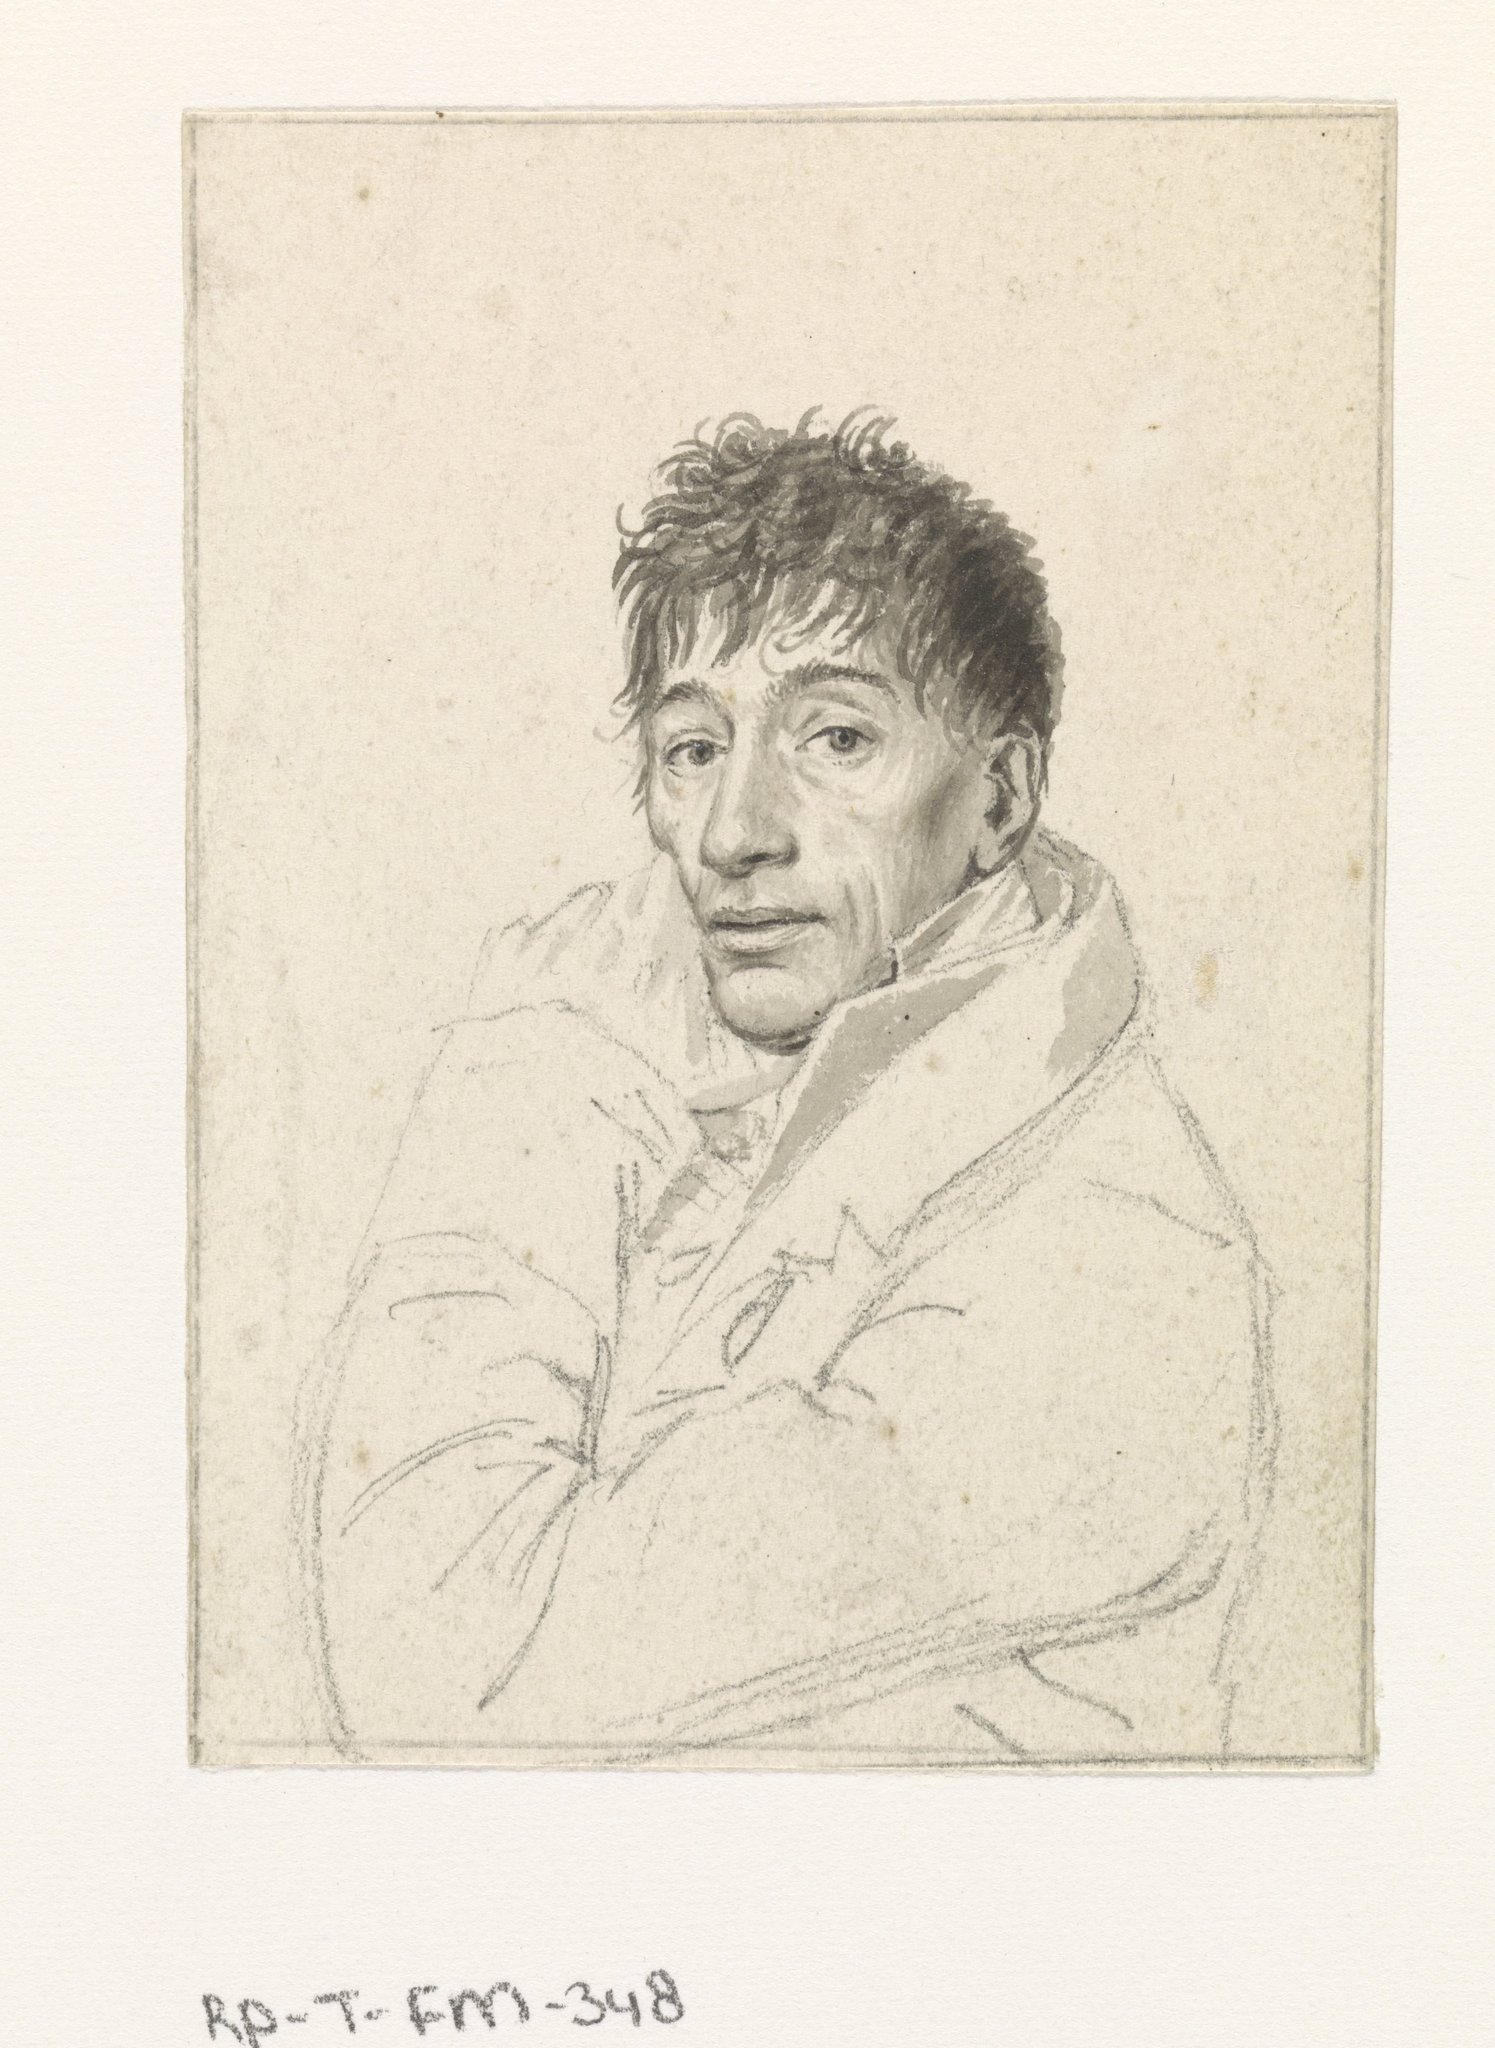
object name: drawing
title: Portret van Antonie van den Bosch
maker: Anonymous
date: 1800-1850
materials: paper, pencil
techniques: brush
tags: amsterdam, print maker, draughtsman, anthonie van den bos, historical persons, portrait, self-portrait of painter, portrait, self-portrait of artist, portrait, self-portrait of draughtsman